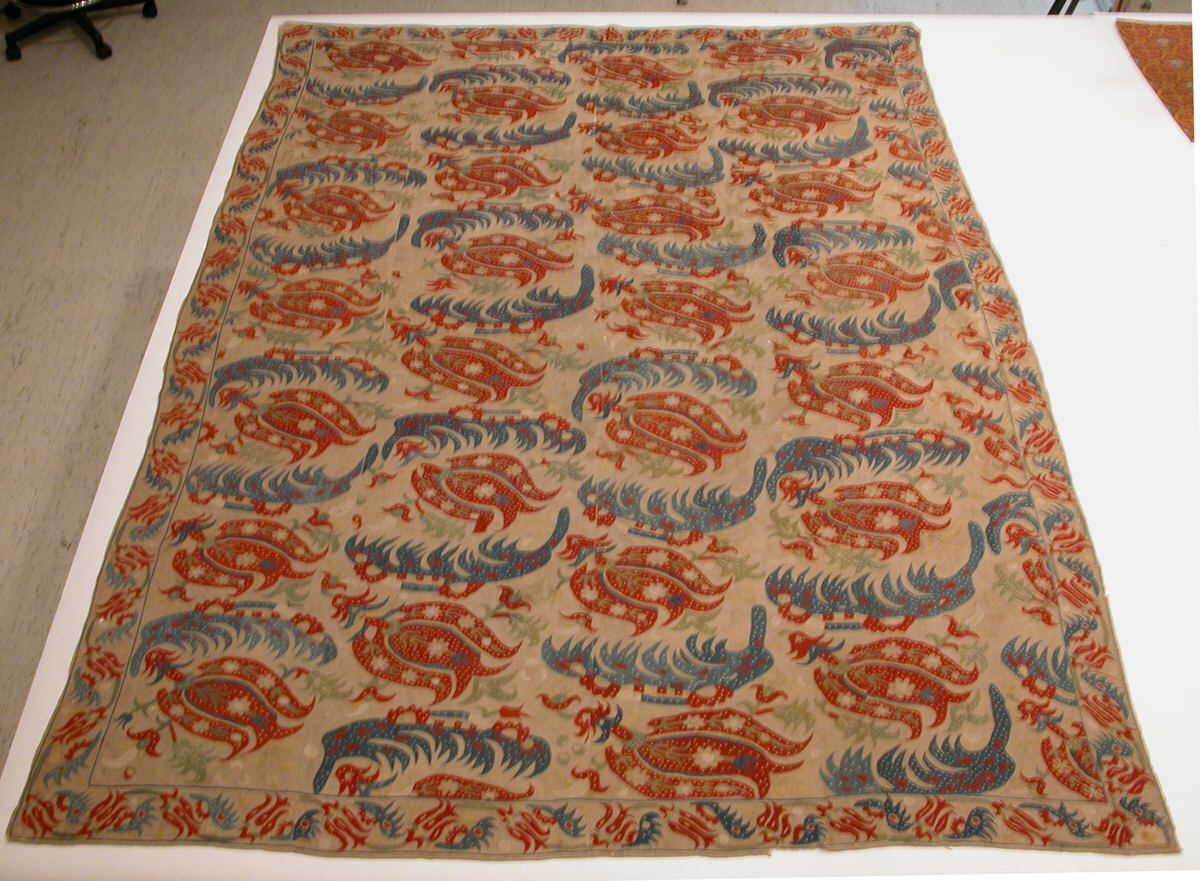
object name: hanging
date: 1601-1800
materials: cotton, silk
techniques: embroidery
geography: greece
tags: flowers